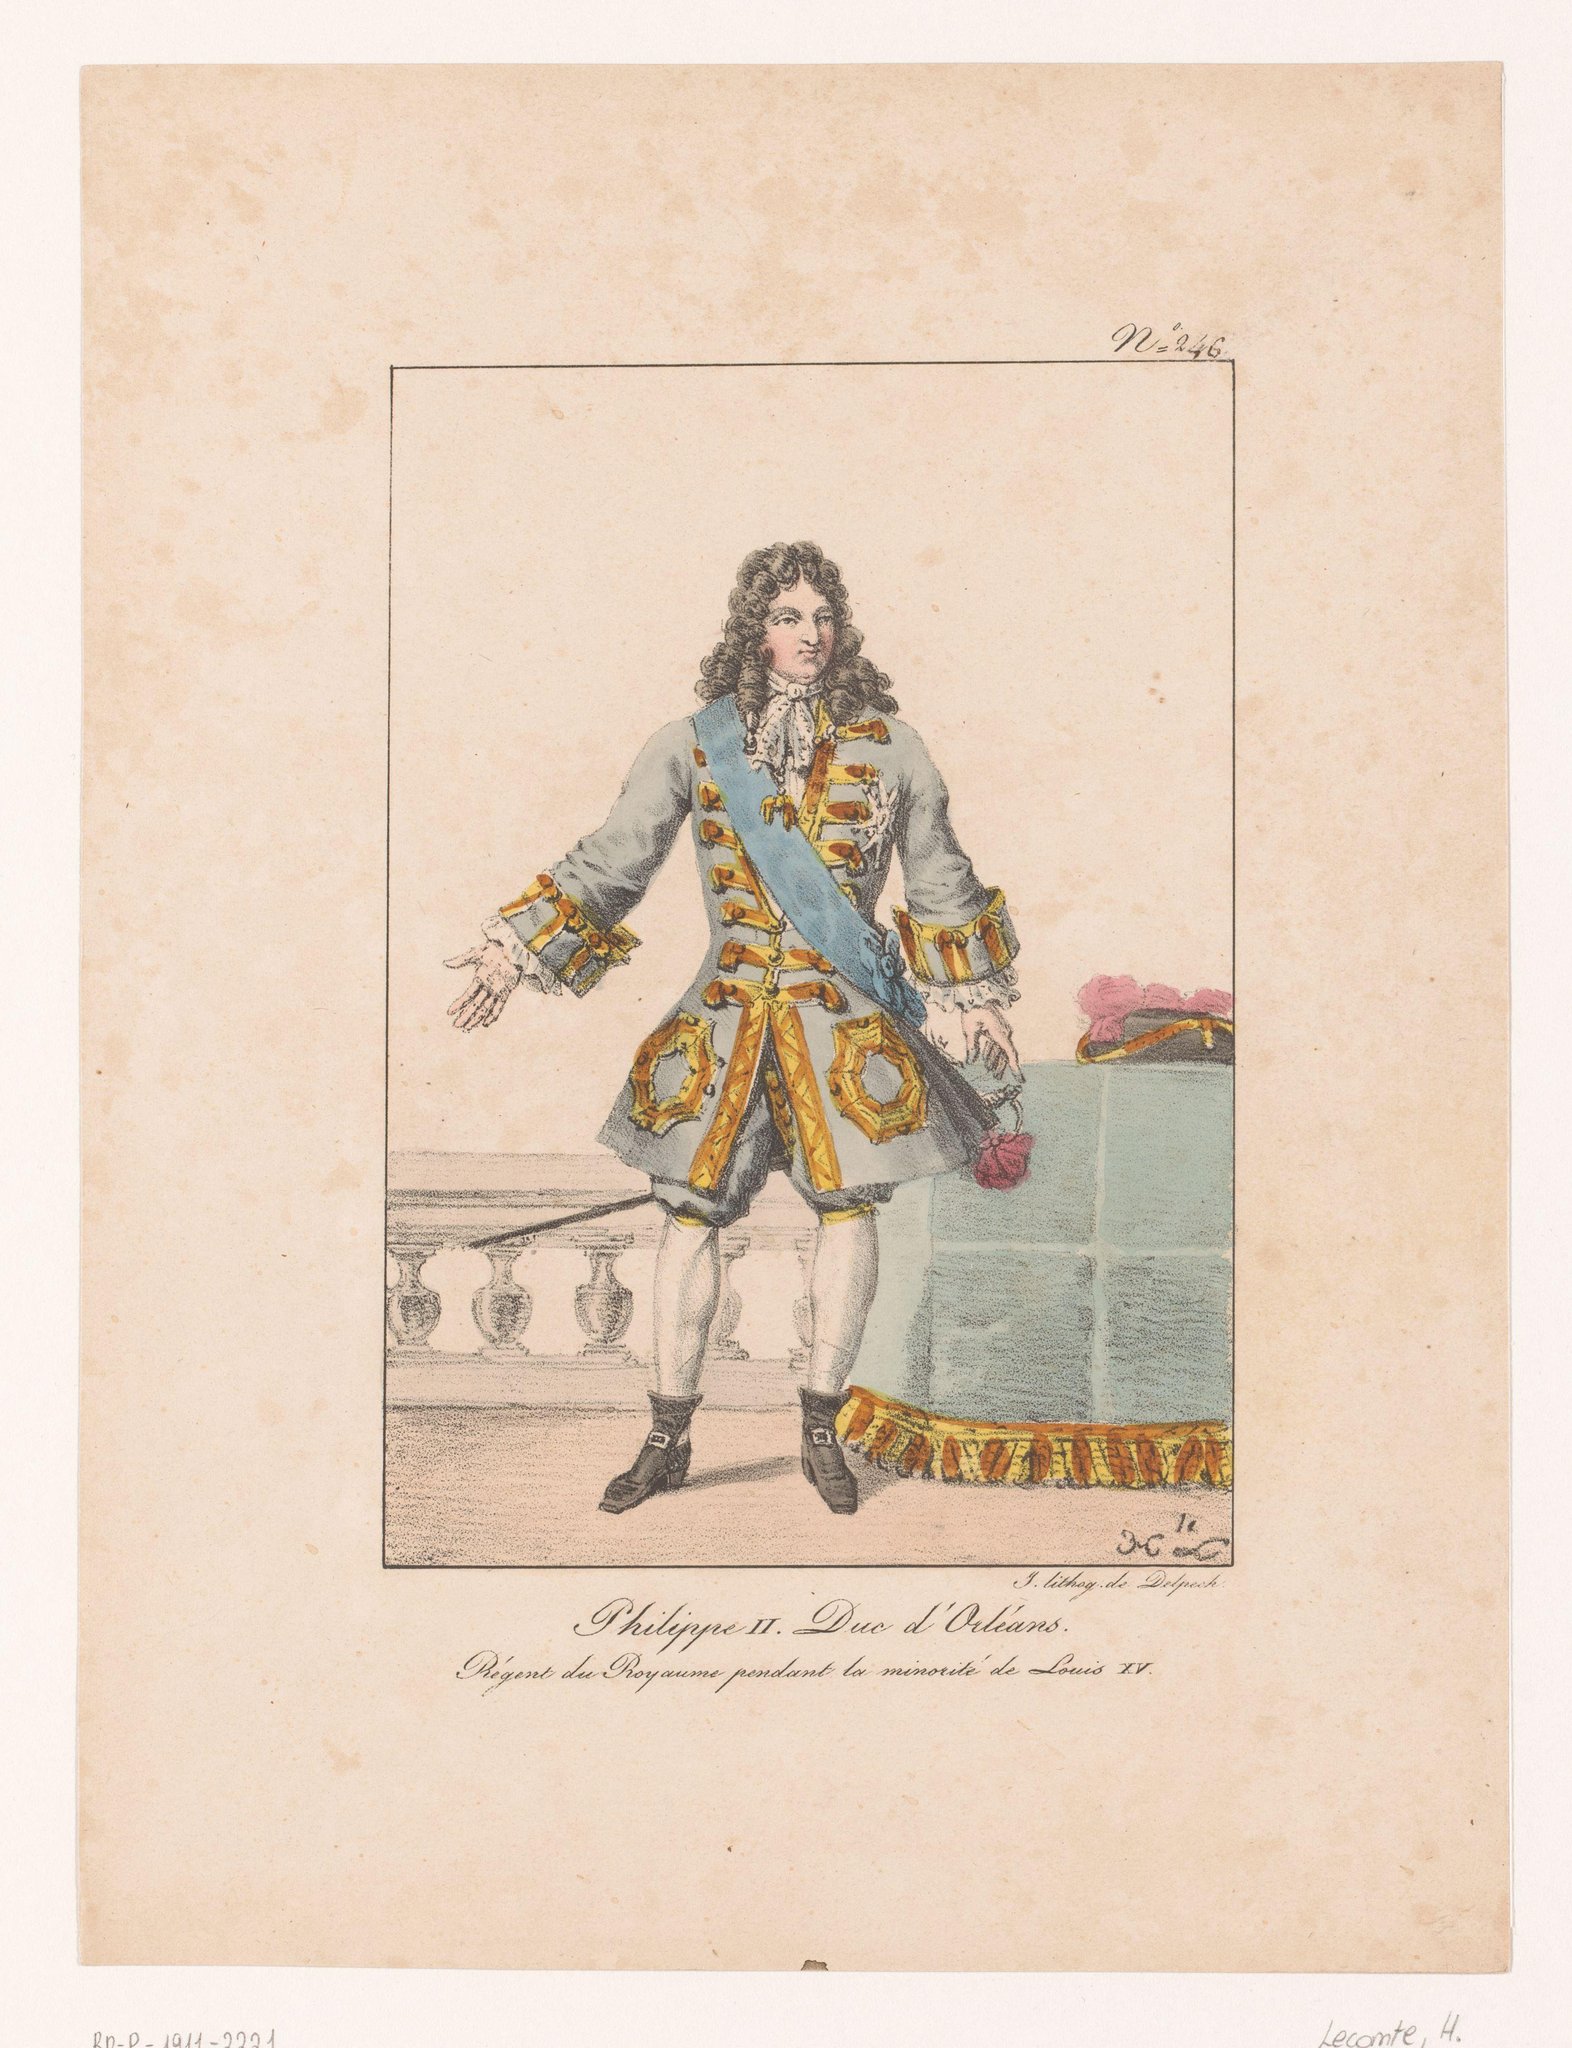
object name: print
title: Burgerlijke en militaire kostuums uit Frankrijk van 1200 tot 1820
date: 1820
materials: paper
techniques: hand coloring, lithograph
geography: paris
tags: filips ii (hertog van orléans), official; civil servant; functionary (in general), historical persons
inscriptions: collector's mark: Lugt 2228a